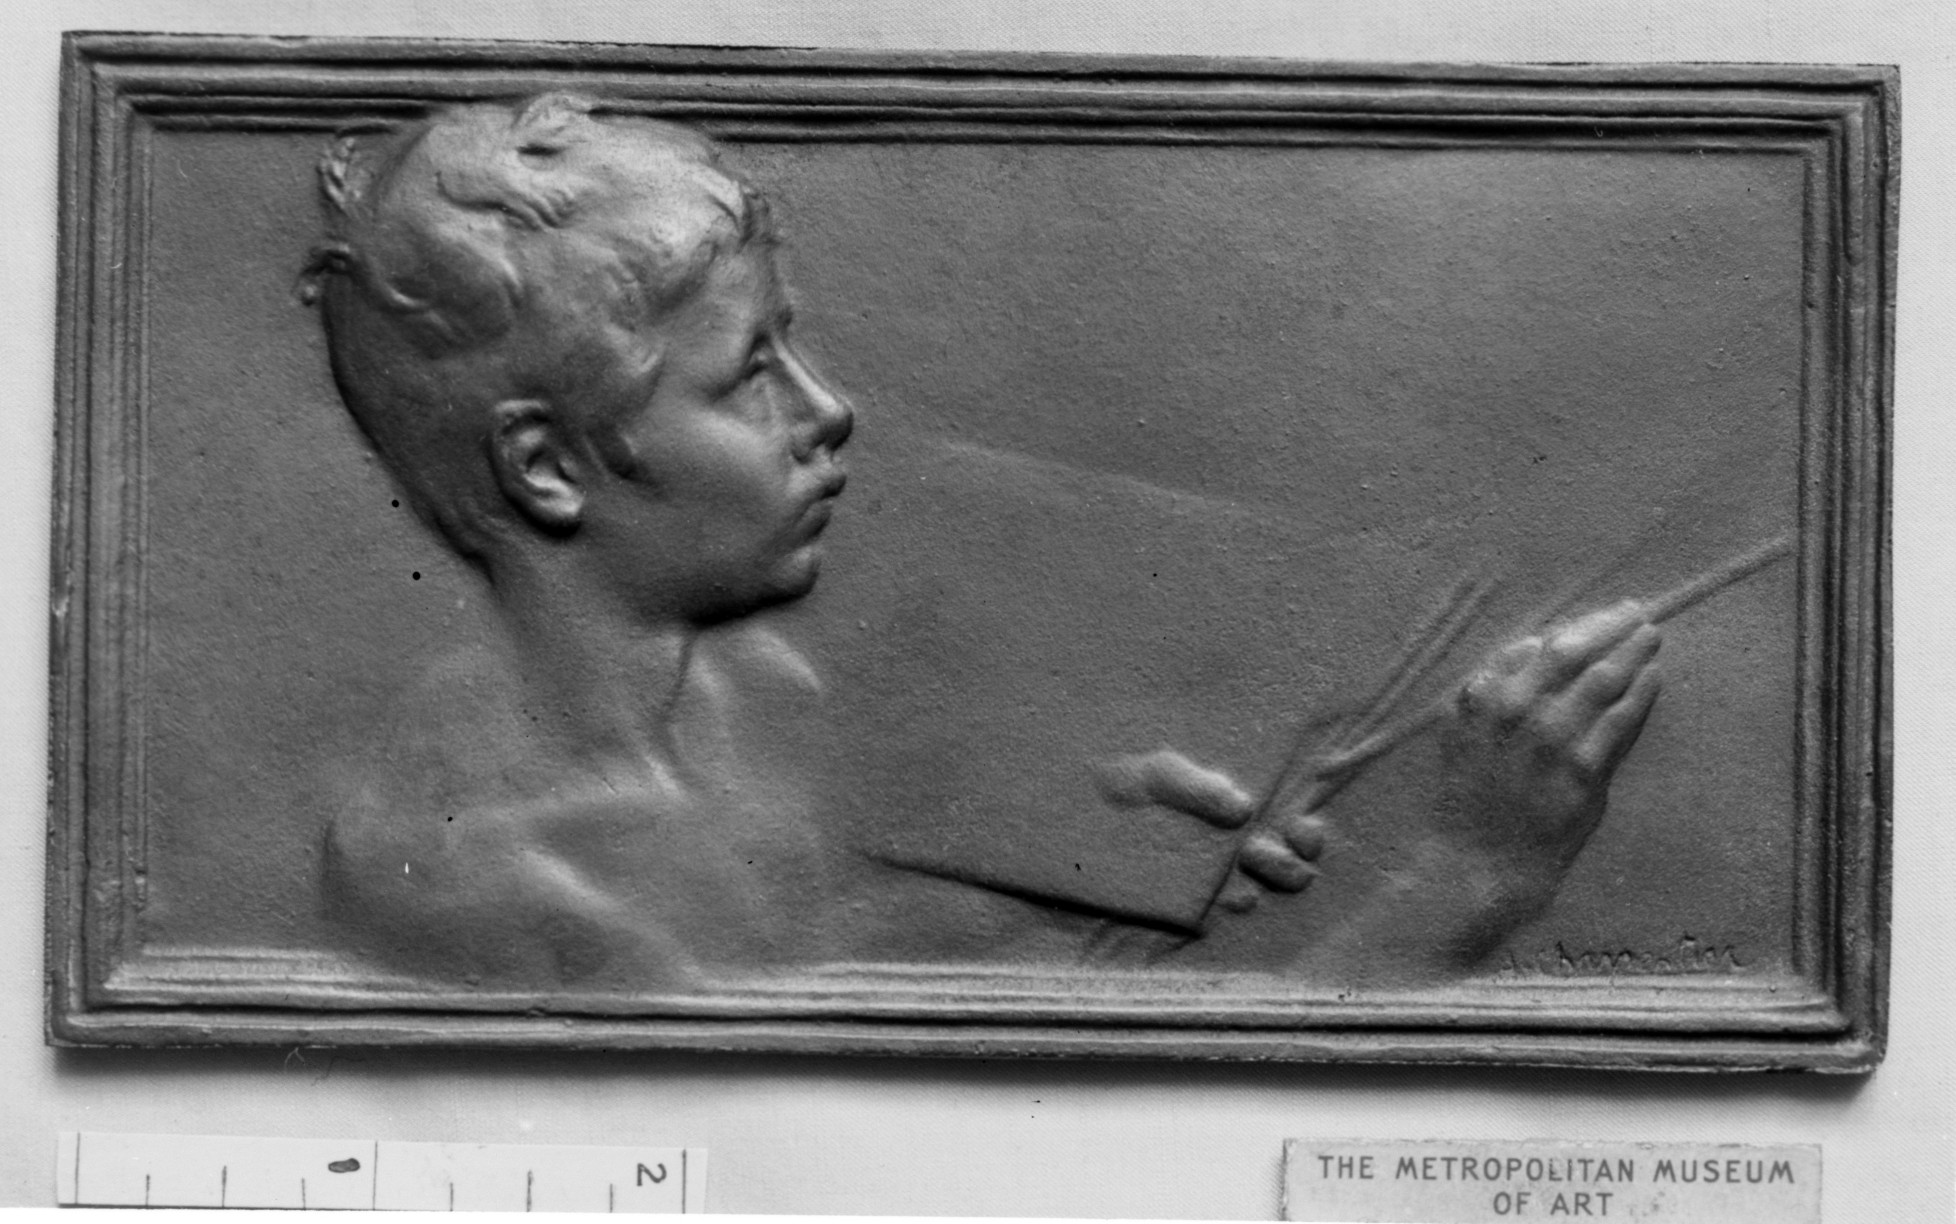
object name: plaquette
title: Nude bust of a boy painting (La Peinture) (one of a pair of designs for lock-plates)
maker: alexandre-louis-marie charpentier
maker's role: artist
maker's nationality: french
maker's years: 1856-1909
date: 1867-1900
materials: bronze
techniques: casting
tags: painting,boys,brushes